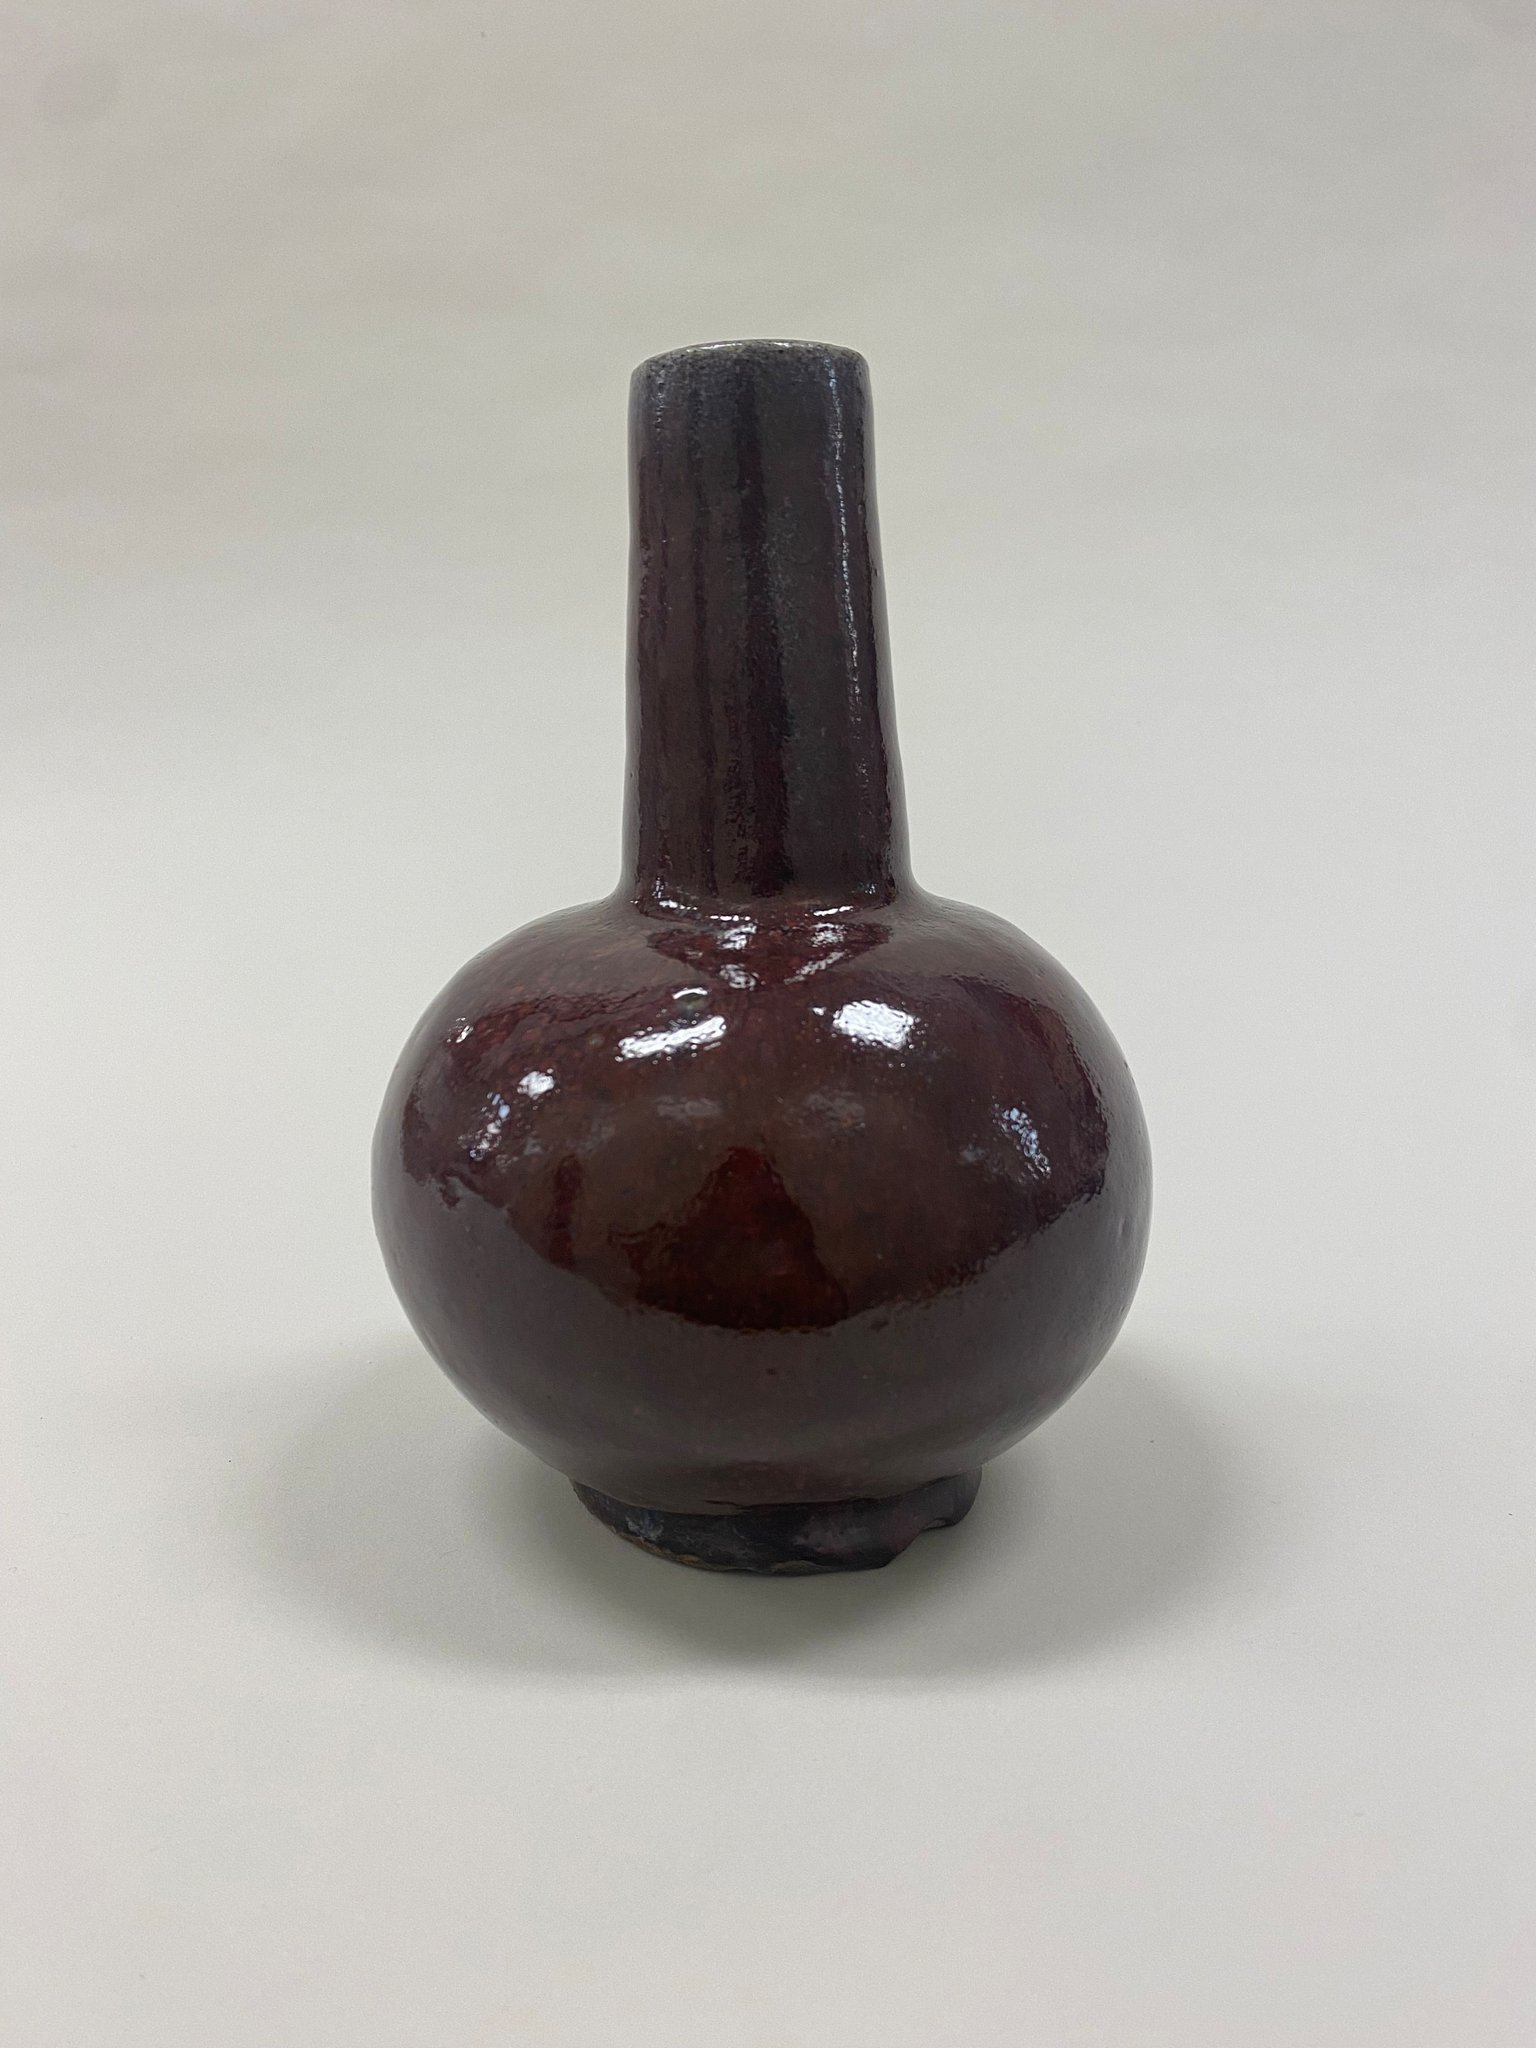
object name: vase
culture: chinese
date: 1801-1900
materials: glaze, stoneware